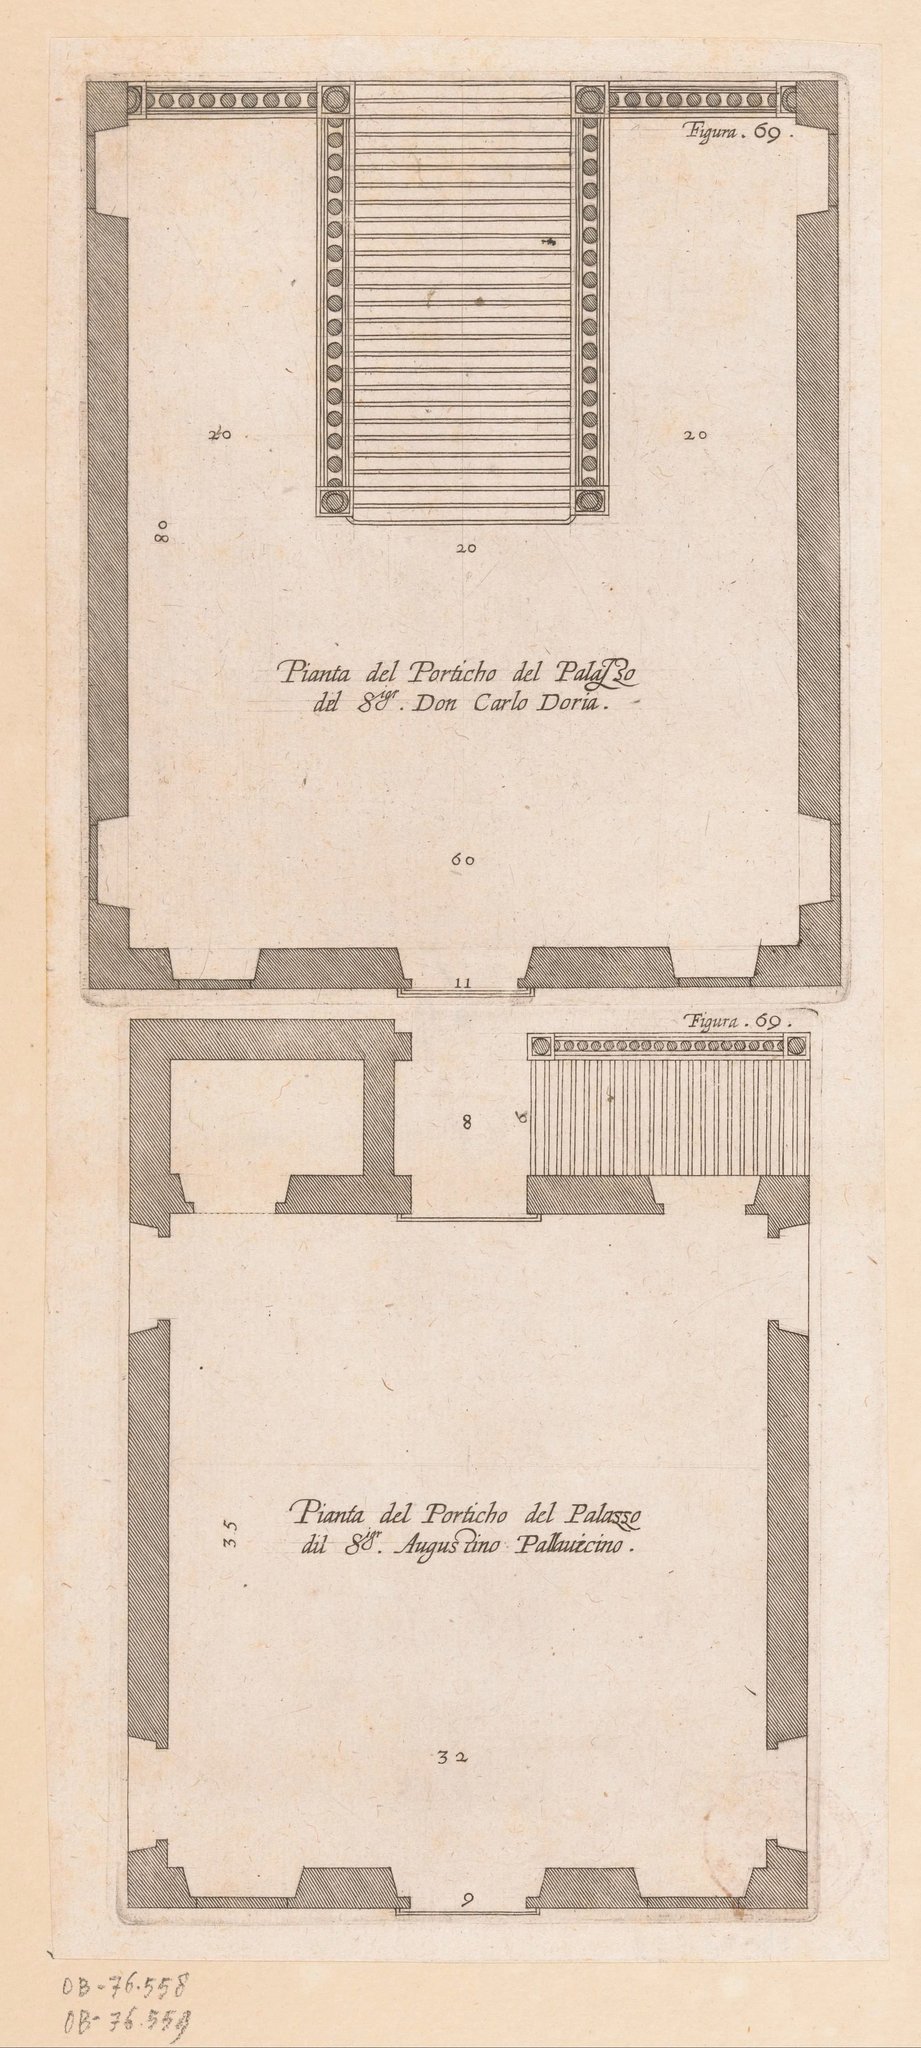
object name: ornament print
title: Palazzi di Genova / Palazzi Antichi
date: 1622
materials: paper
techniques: engraving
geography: antwerp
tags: hôtel, i.e. small palace in city, plan ~ architecture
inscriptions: collector's mark: Lugt 240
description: Twee plattegronden op één blad. Met Italiaanse toelichting.